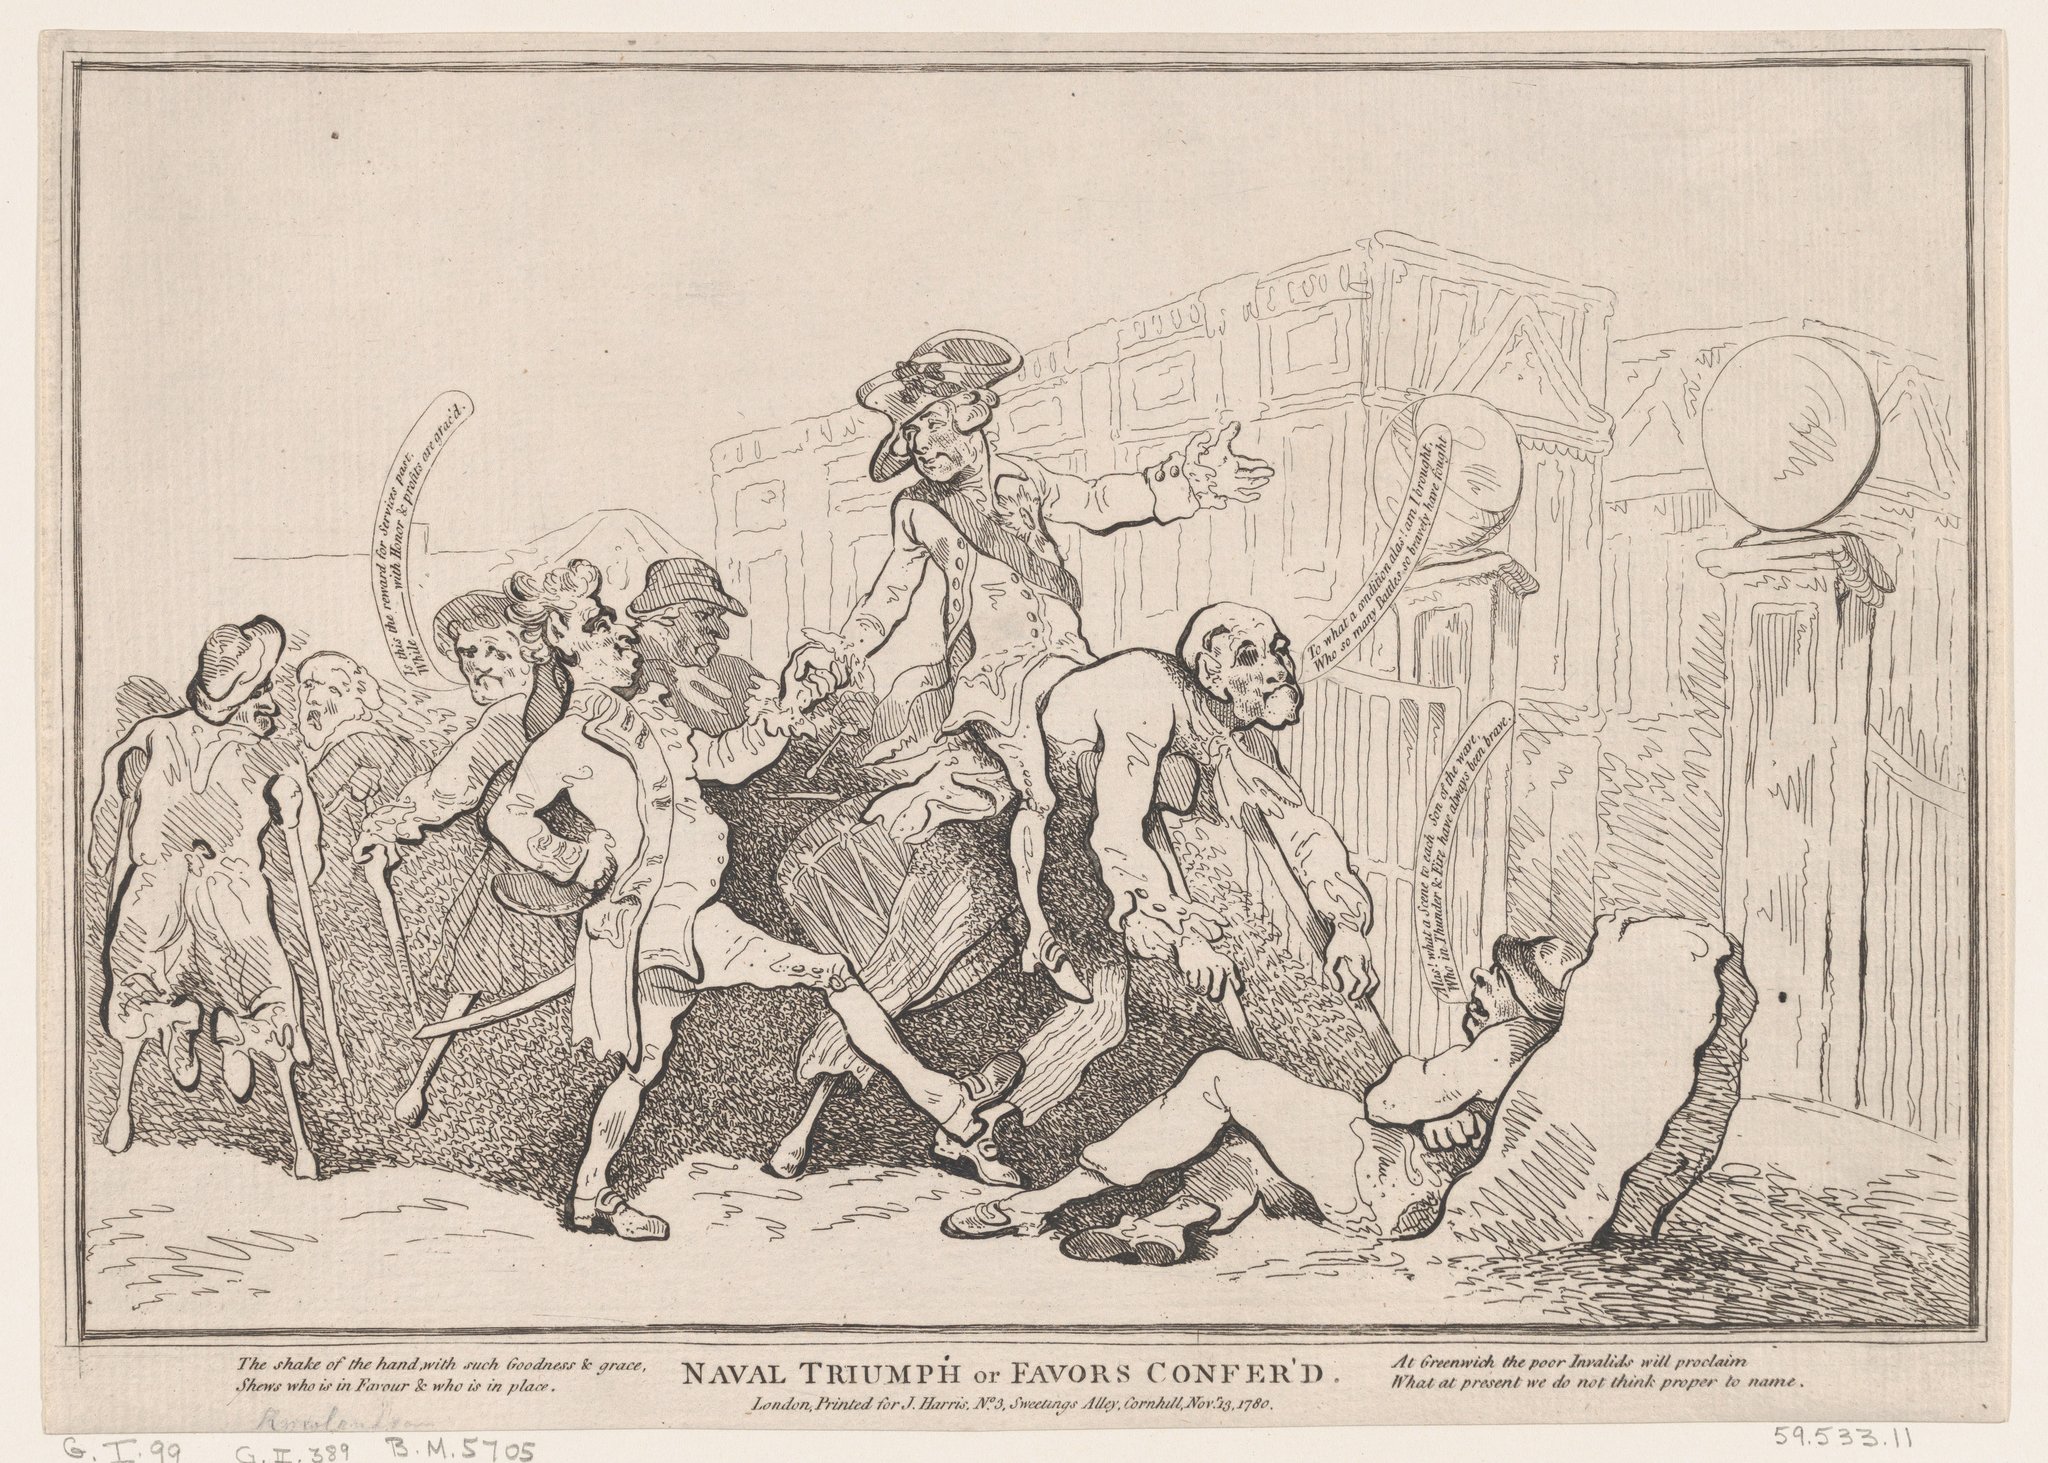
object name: print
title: Naval Triumph, or Favors Conferred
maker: thomas rowlandson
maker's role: artist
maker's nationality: british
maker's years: 1757-1827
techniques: etching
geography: london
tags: satire,men